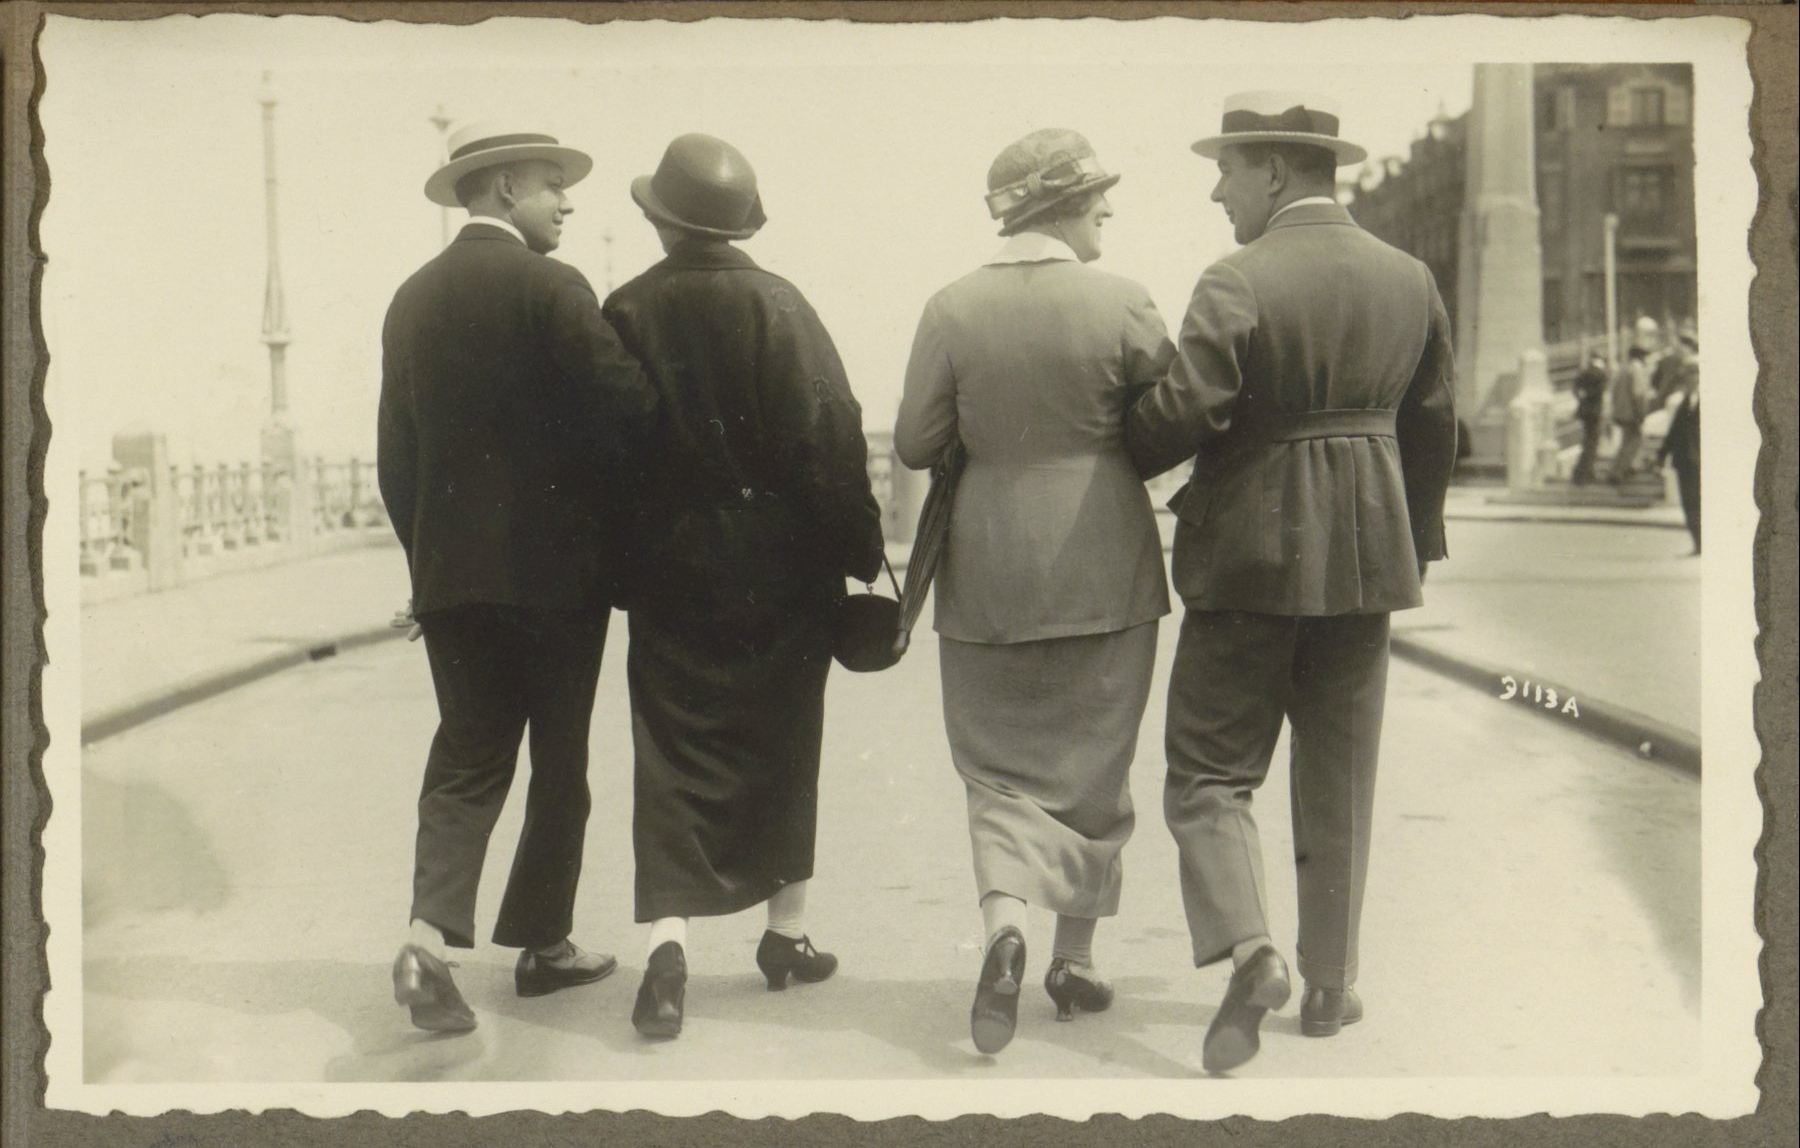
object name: photograph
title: Zondagmorgen op de Boulevard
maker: Anonymous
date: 1905-1924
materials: photographic support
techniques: gelatin silver print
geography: scheveningen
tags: adult woman, strolling, adult man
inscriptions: number: ‘9113A’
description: Onderdeel van fotoalbum van een onbekende Nederlandse familie met opnames van Suriname, Europa en Nederlands-Indië.